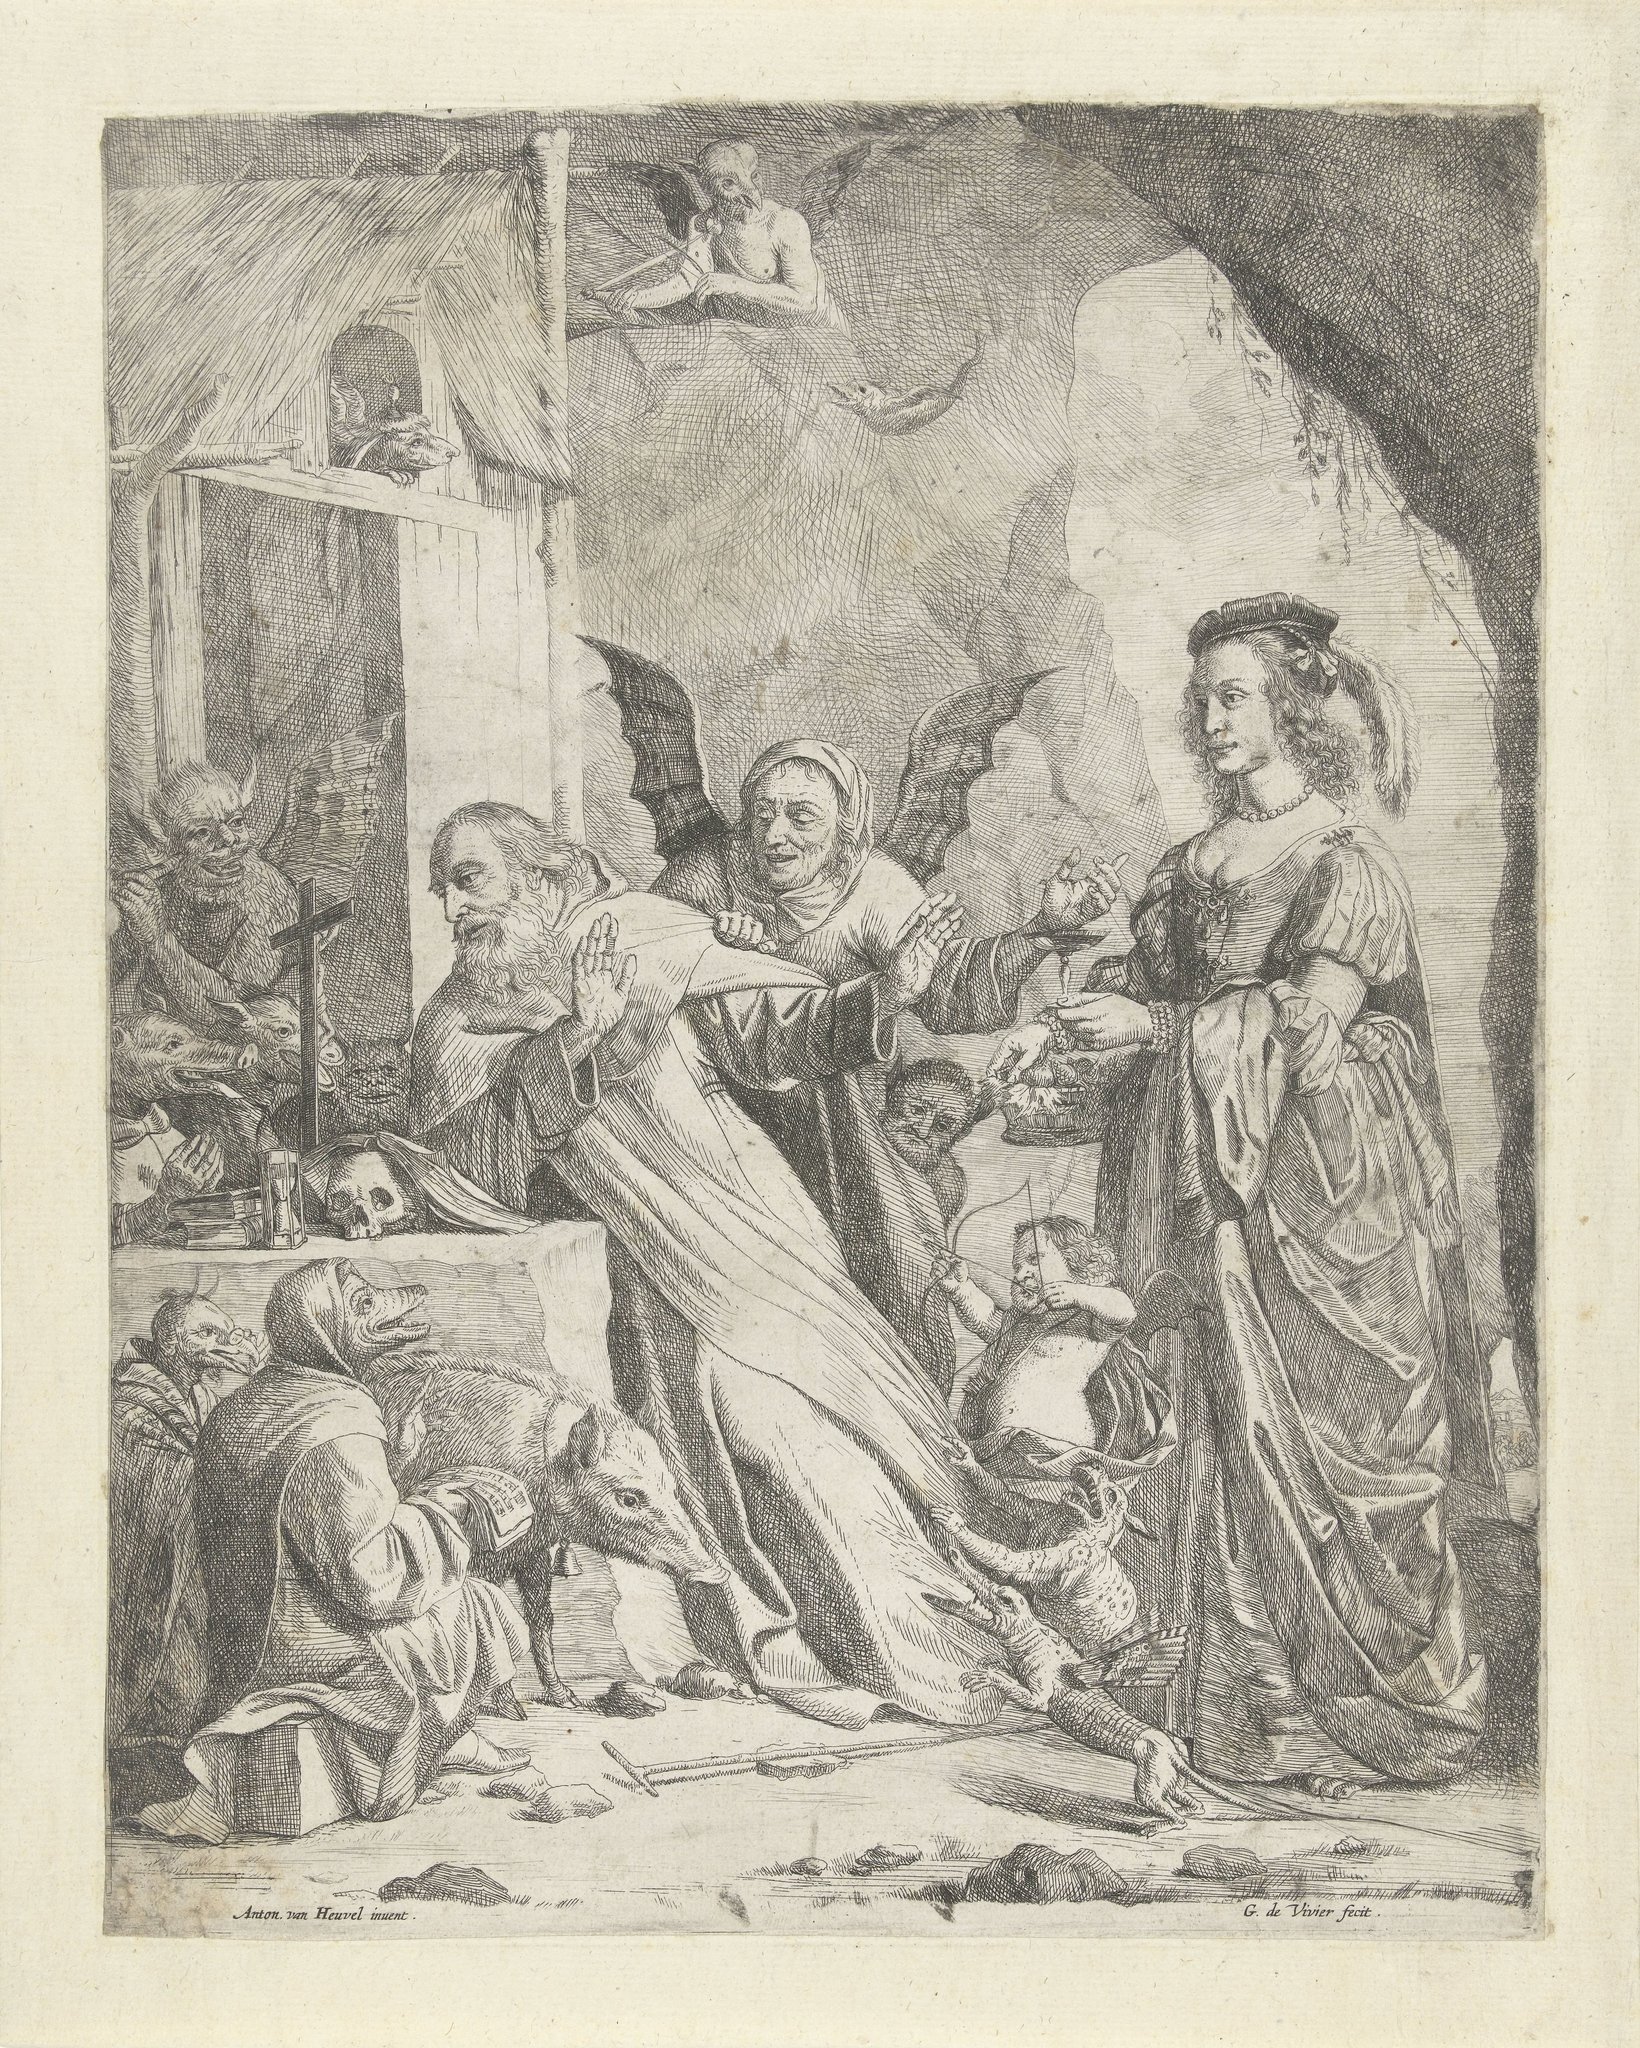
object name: print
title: De verzoeking van de H. Antonius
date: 1660-1670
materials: paper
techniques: etching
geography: southern netherlands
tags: temptations of st. antony abbot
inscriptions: collector's mark: Lugt 240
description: De H. Antonius zit geknield voor een altaarsteen waarop een crucifix, een zandloper, een doodshoofd en een stapel boeken. Duivel- en monsterachtige wezens trekken hem aan zijn kleed en belagen hem op allerlei manieren. Voor hem het varken. Achter hem een fraai geklede dame die hem een glas wijn aanbiedt. Een oude vrouw met duivelsvleugels probeert hem te verleiden naar haar om te kijken. Boven in de grot een vliegend duiveltje dat een kakebeen bespeelt.